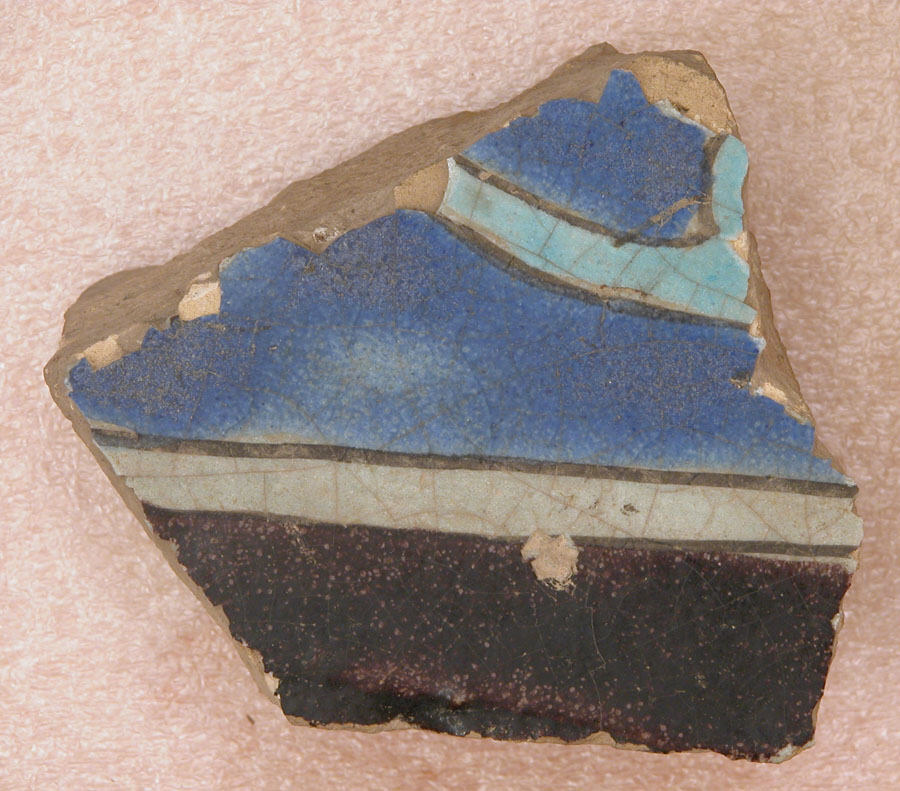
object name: tile fragment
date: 1334-1434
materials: glaze, stonepaste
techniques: painting, polychrome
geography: uzbekistan